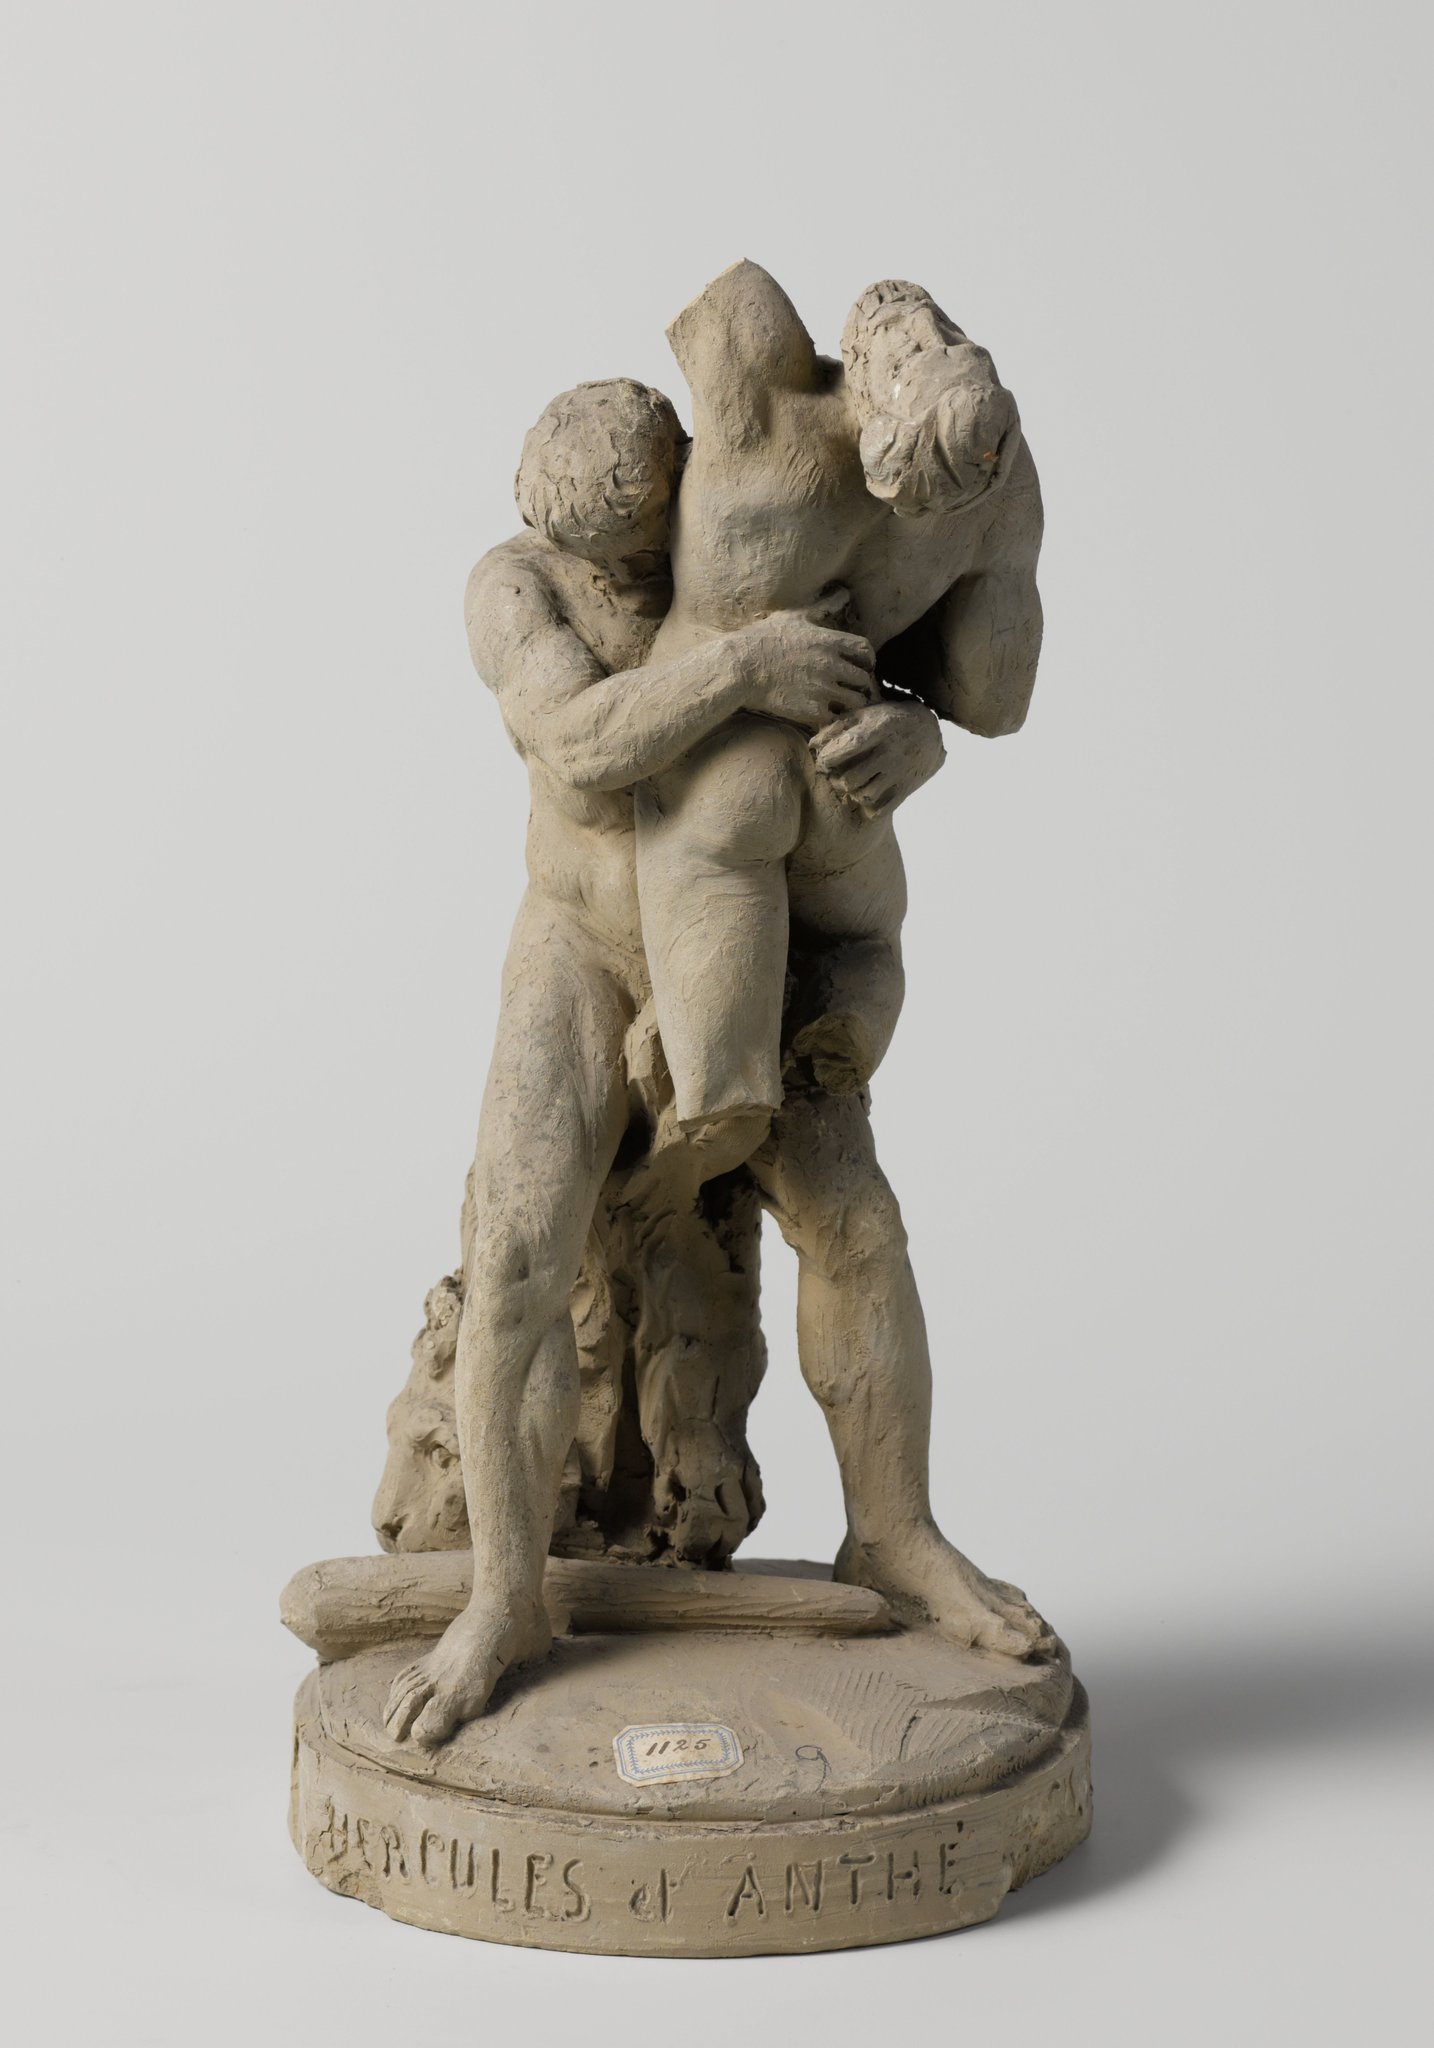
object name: sculpture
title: Hercules en Antaeus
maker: eugène lacomblé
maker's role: draughtsman, painter, sculptor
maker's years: 1828-1905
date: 1877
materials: clay